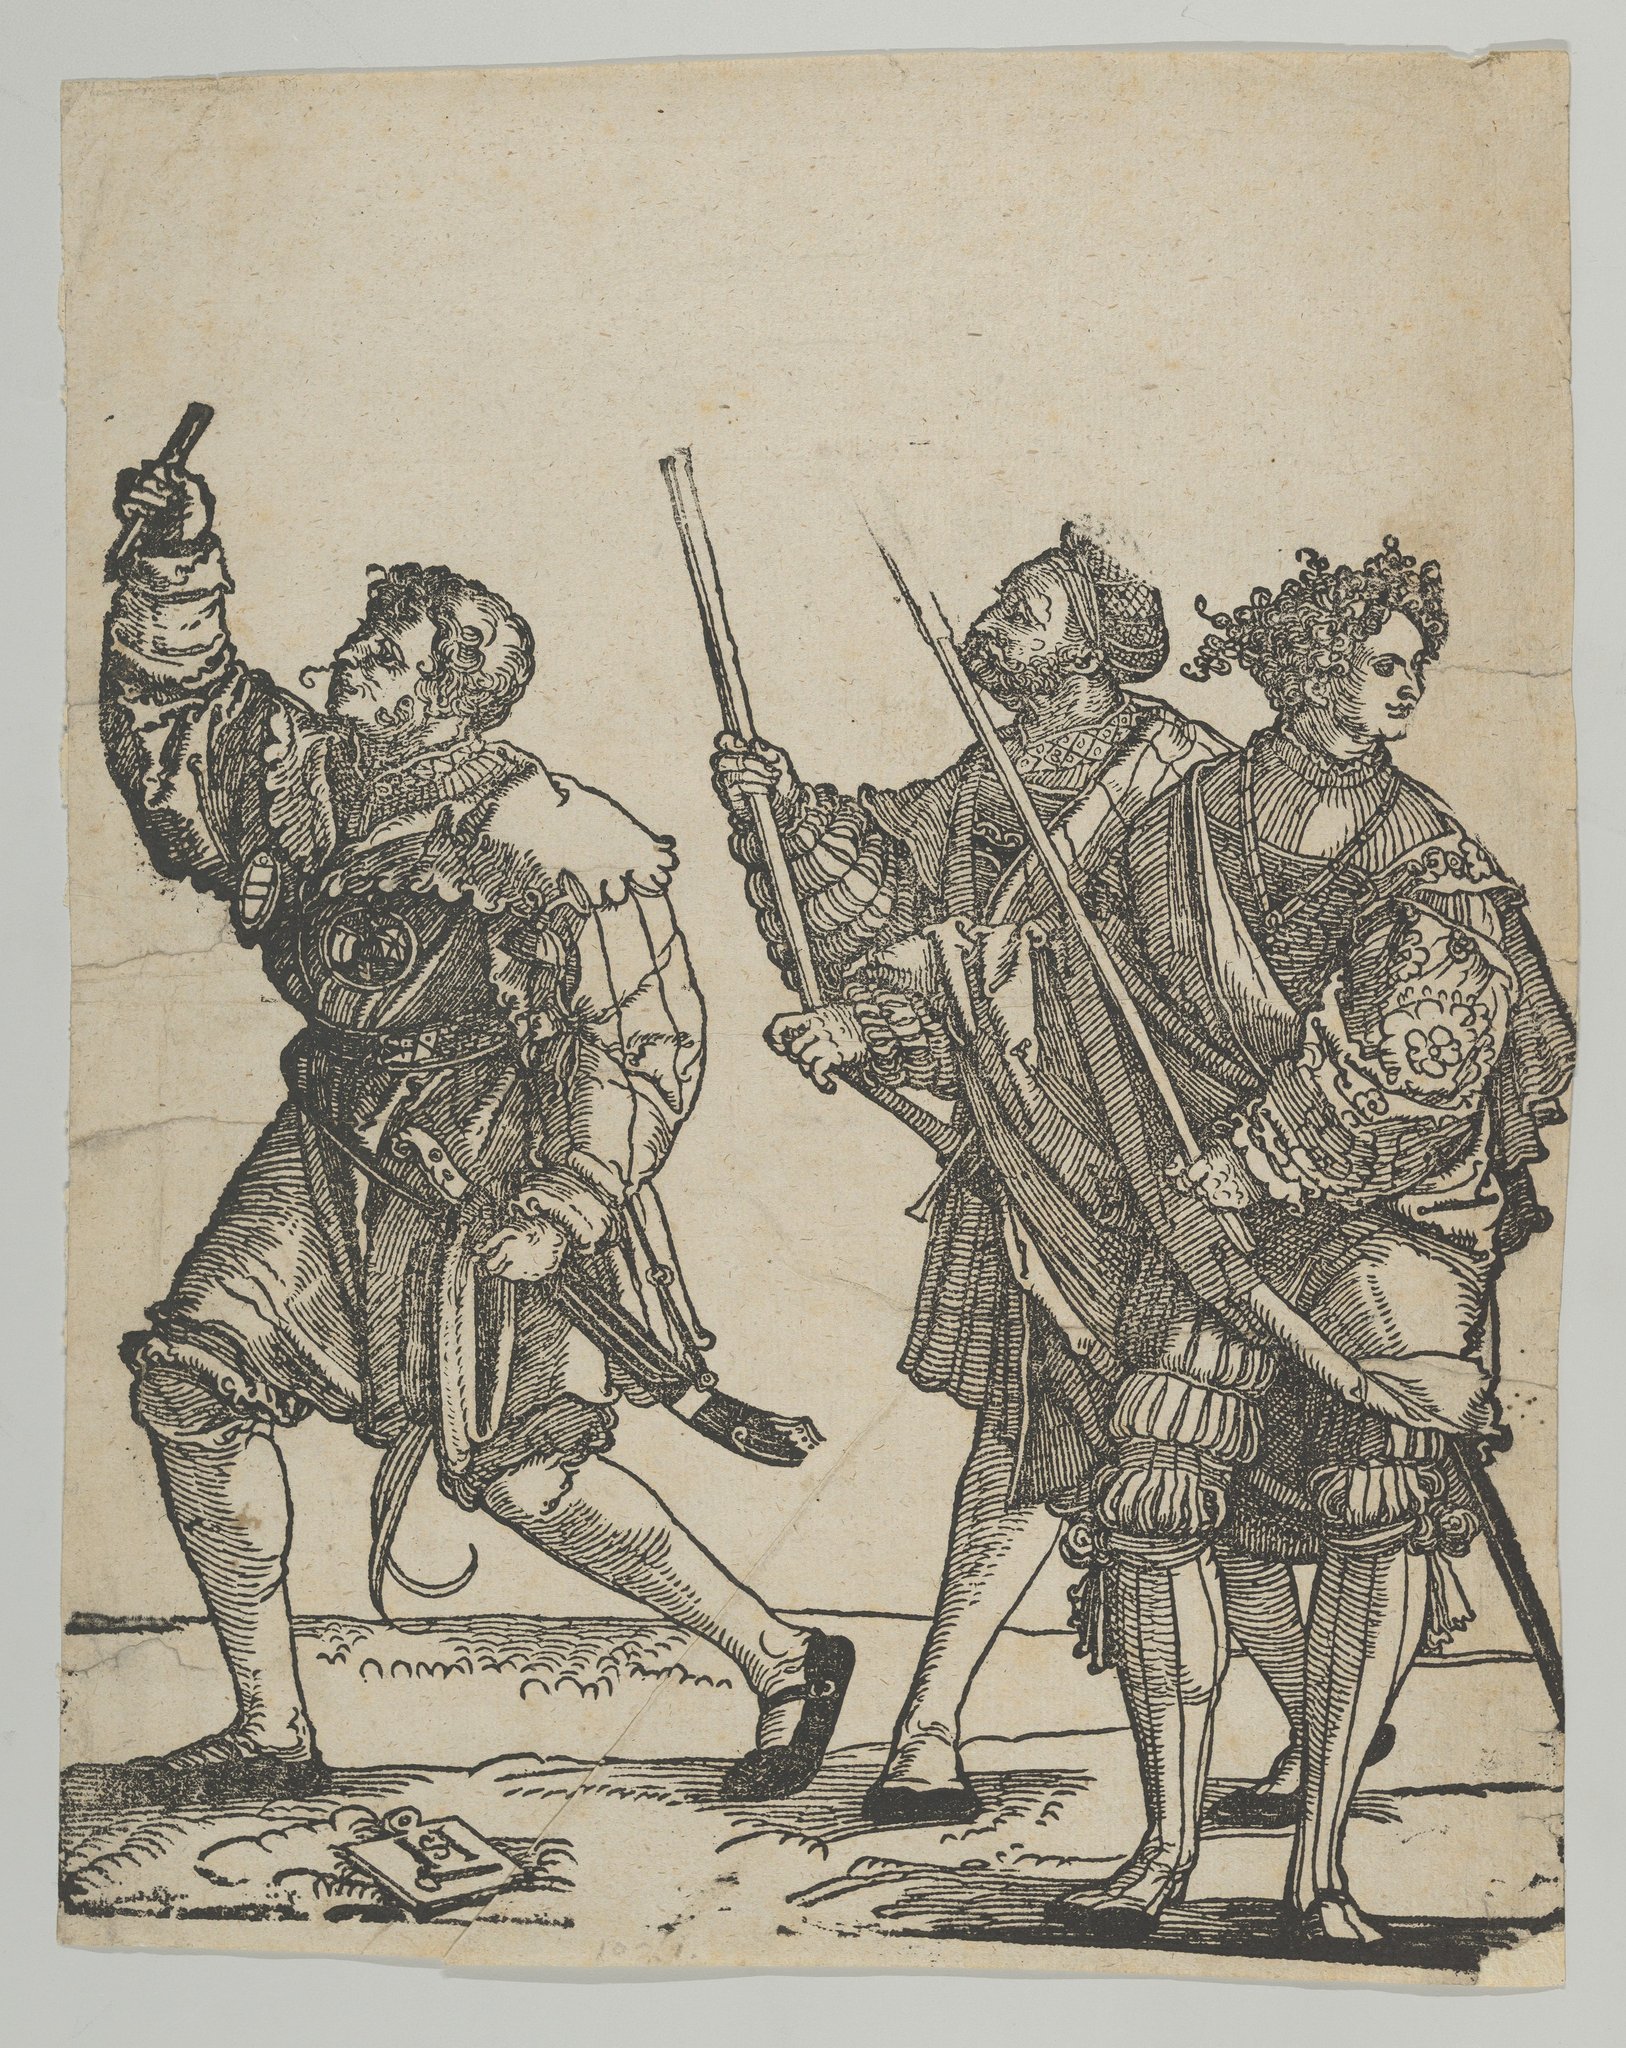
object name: print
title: Master of Ceremonies and Torchbearer, from The Wedding Dancers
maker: hans schäufelein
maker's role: artist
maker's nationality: german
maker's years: 1480-1540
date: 1500-1540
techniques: woodcut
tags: swords,men